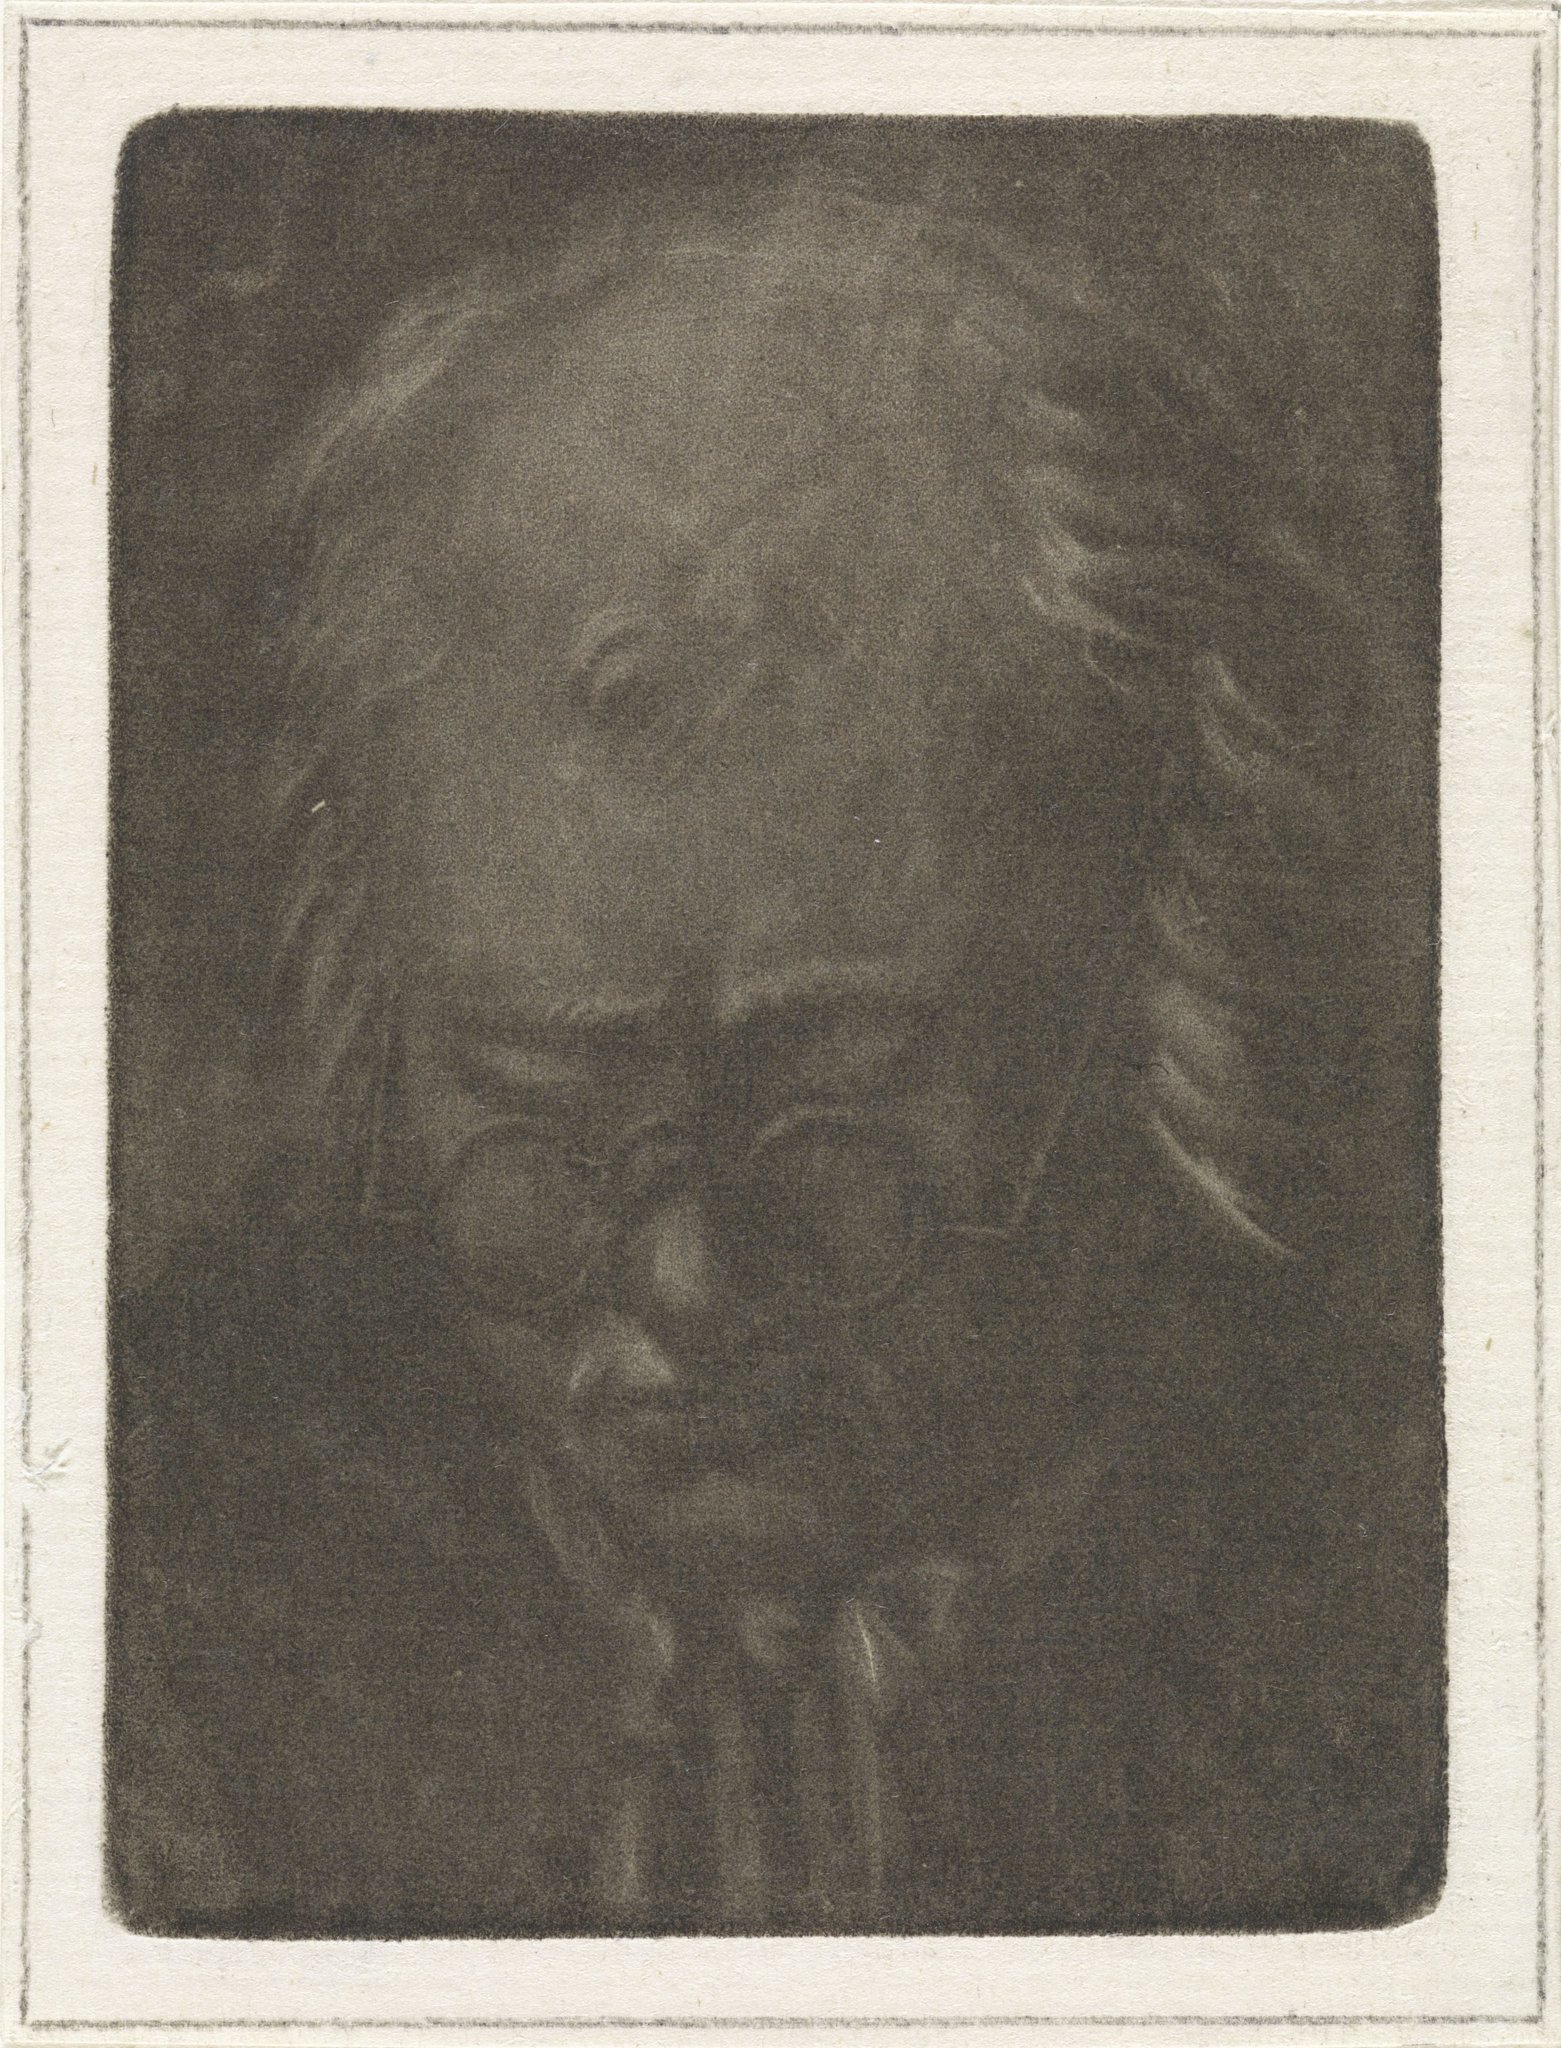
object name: print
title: Hoofd van een oude man met bril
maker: anthonie van den bos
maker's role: draughtsman, print maker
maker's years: 1763-1838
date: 1778-1838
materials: paper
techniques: mezzotint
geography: amsterdam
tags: eyeglasses, spectacles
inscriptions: collector's mark: Lugt 2228